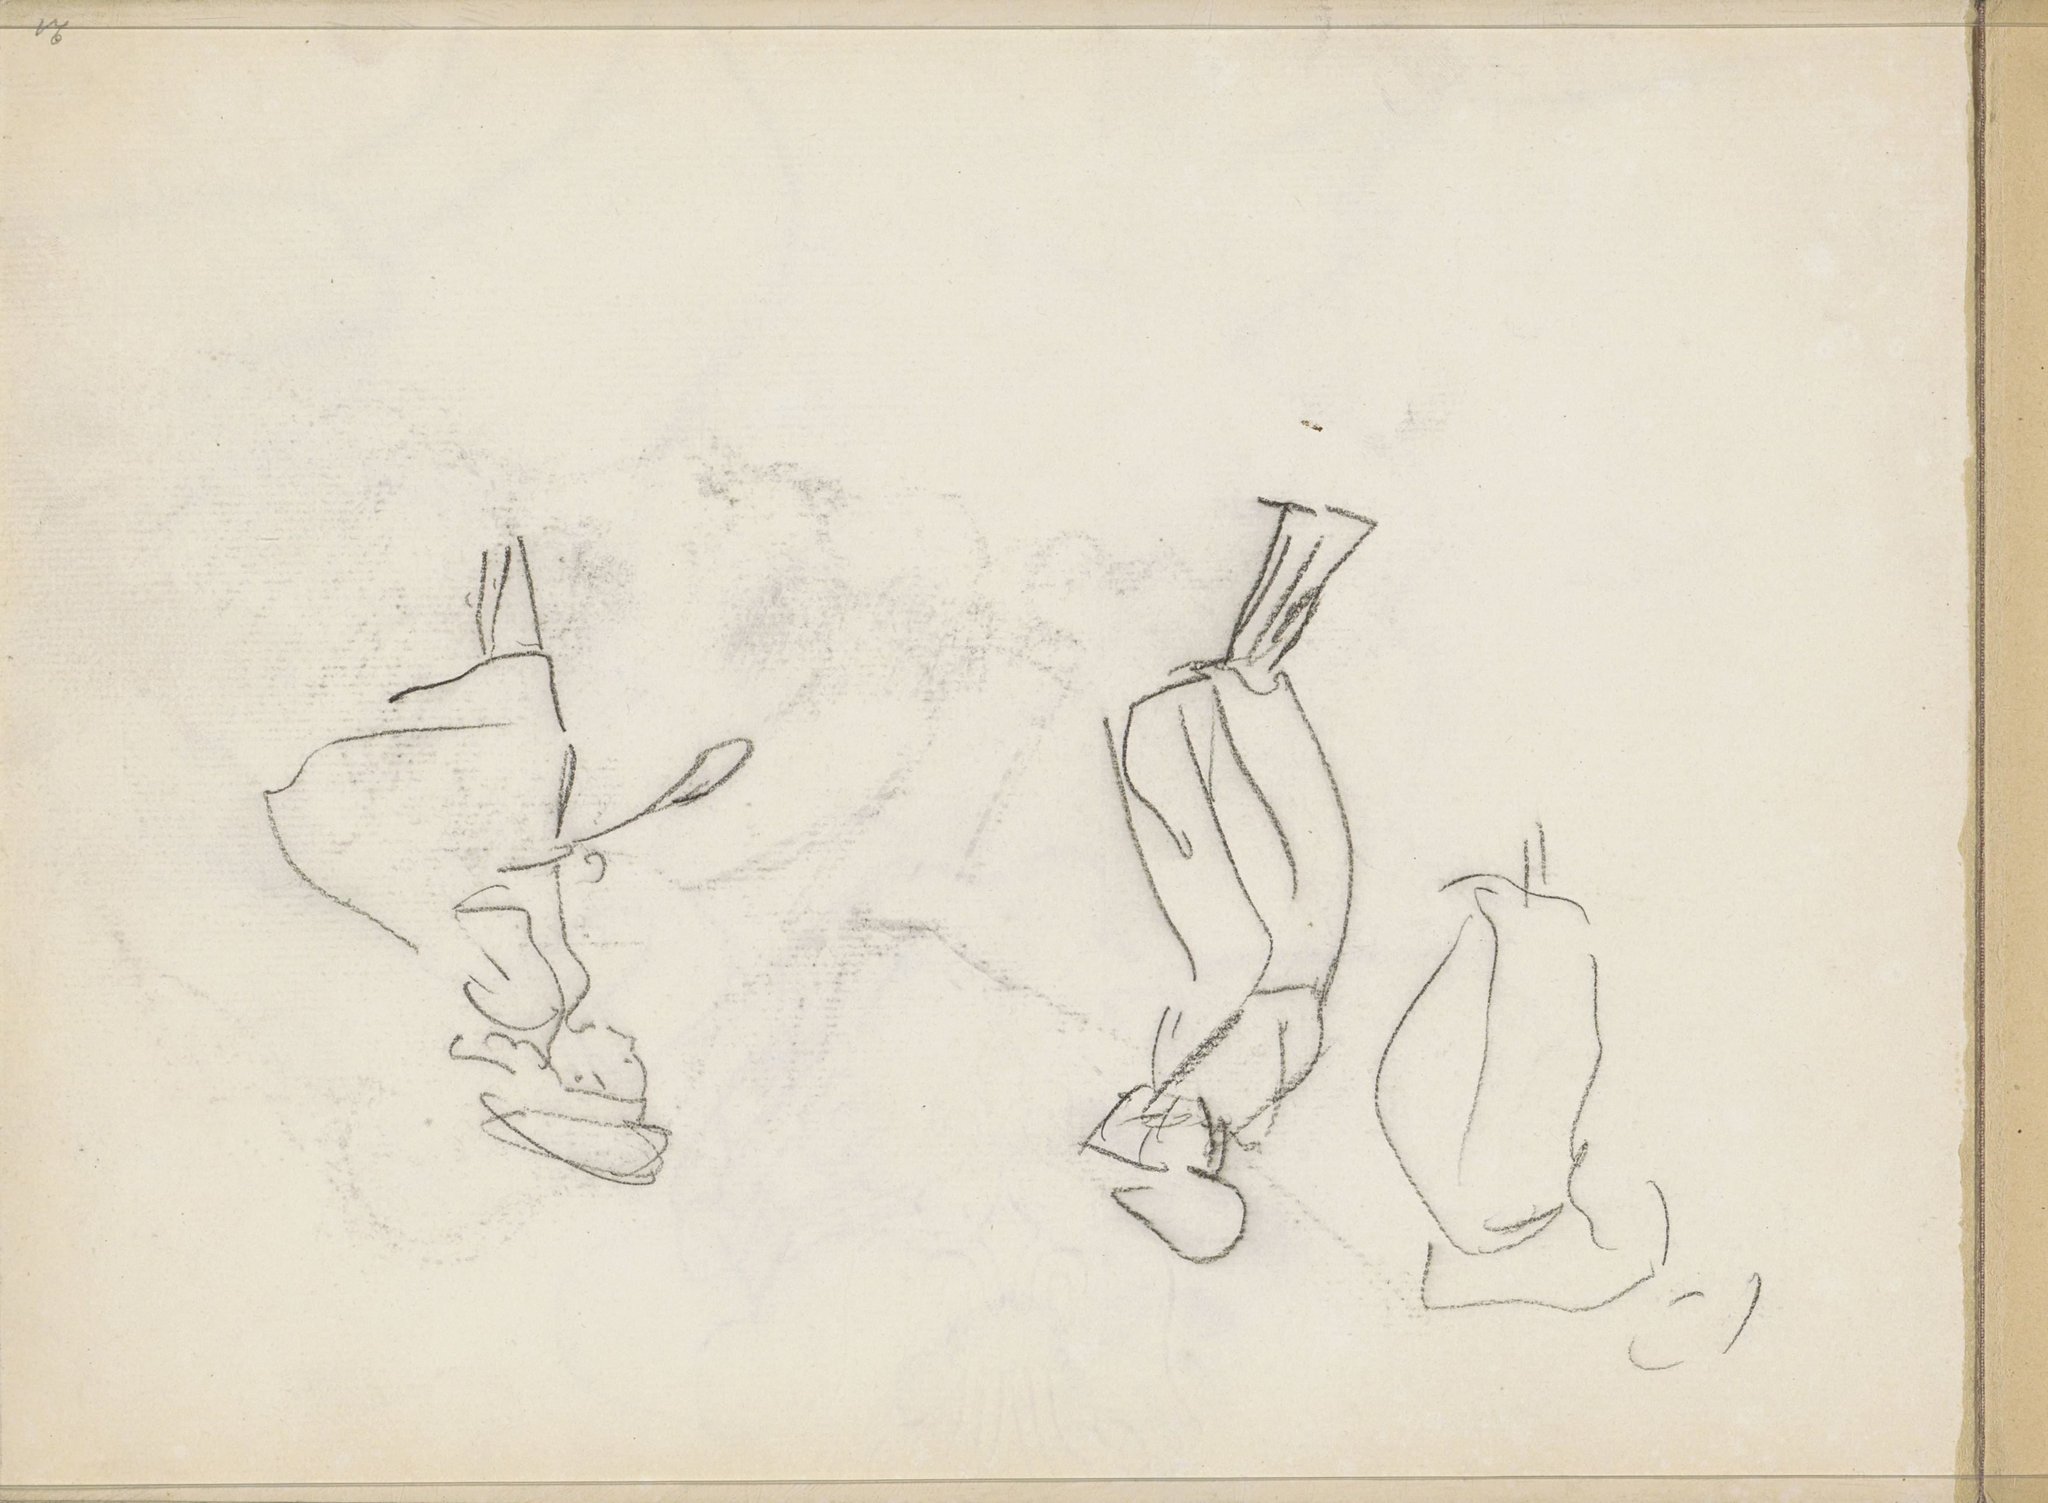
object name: sketchbook leaf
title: Spelende meisjes, mogelijk op het strand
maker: isaac israels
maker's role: draughtsman, painter, print maker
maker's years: 1865-1934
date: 1875-1934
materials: chalk, paper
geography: the hague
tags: beach (as place of recreation), girl (child between toddler and youth)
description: Blad 18 verso uit schetsboek XXI met 19 bladen.